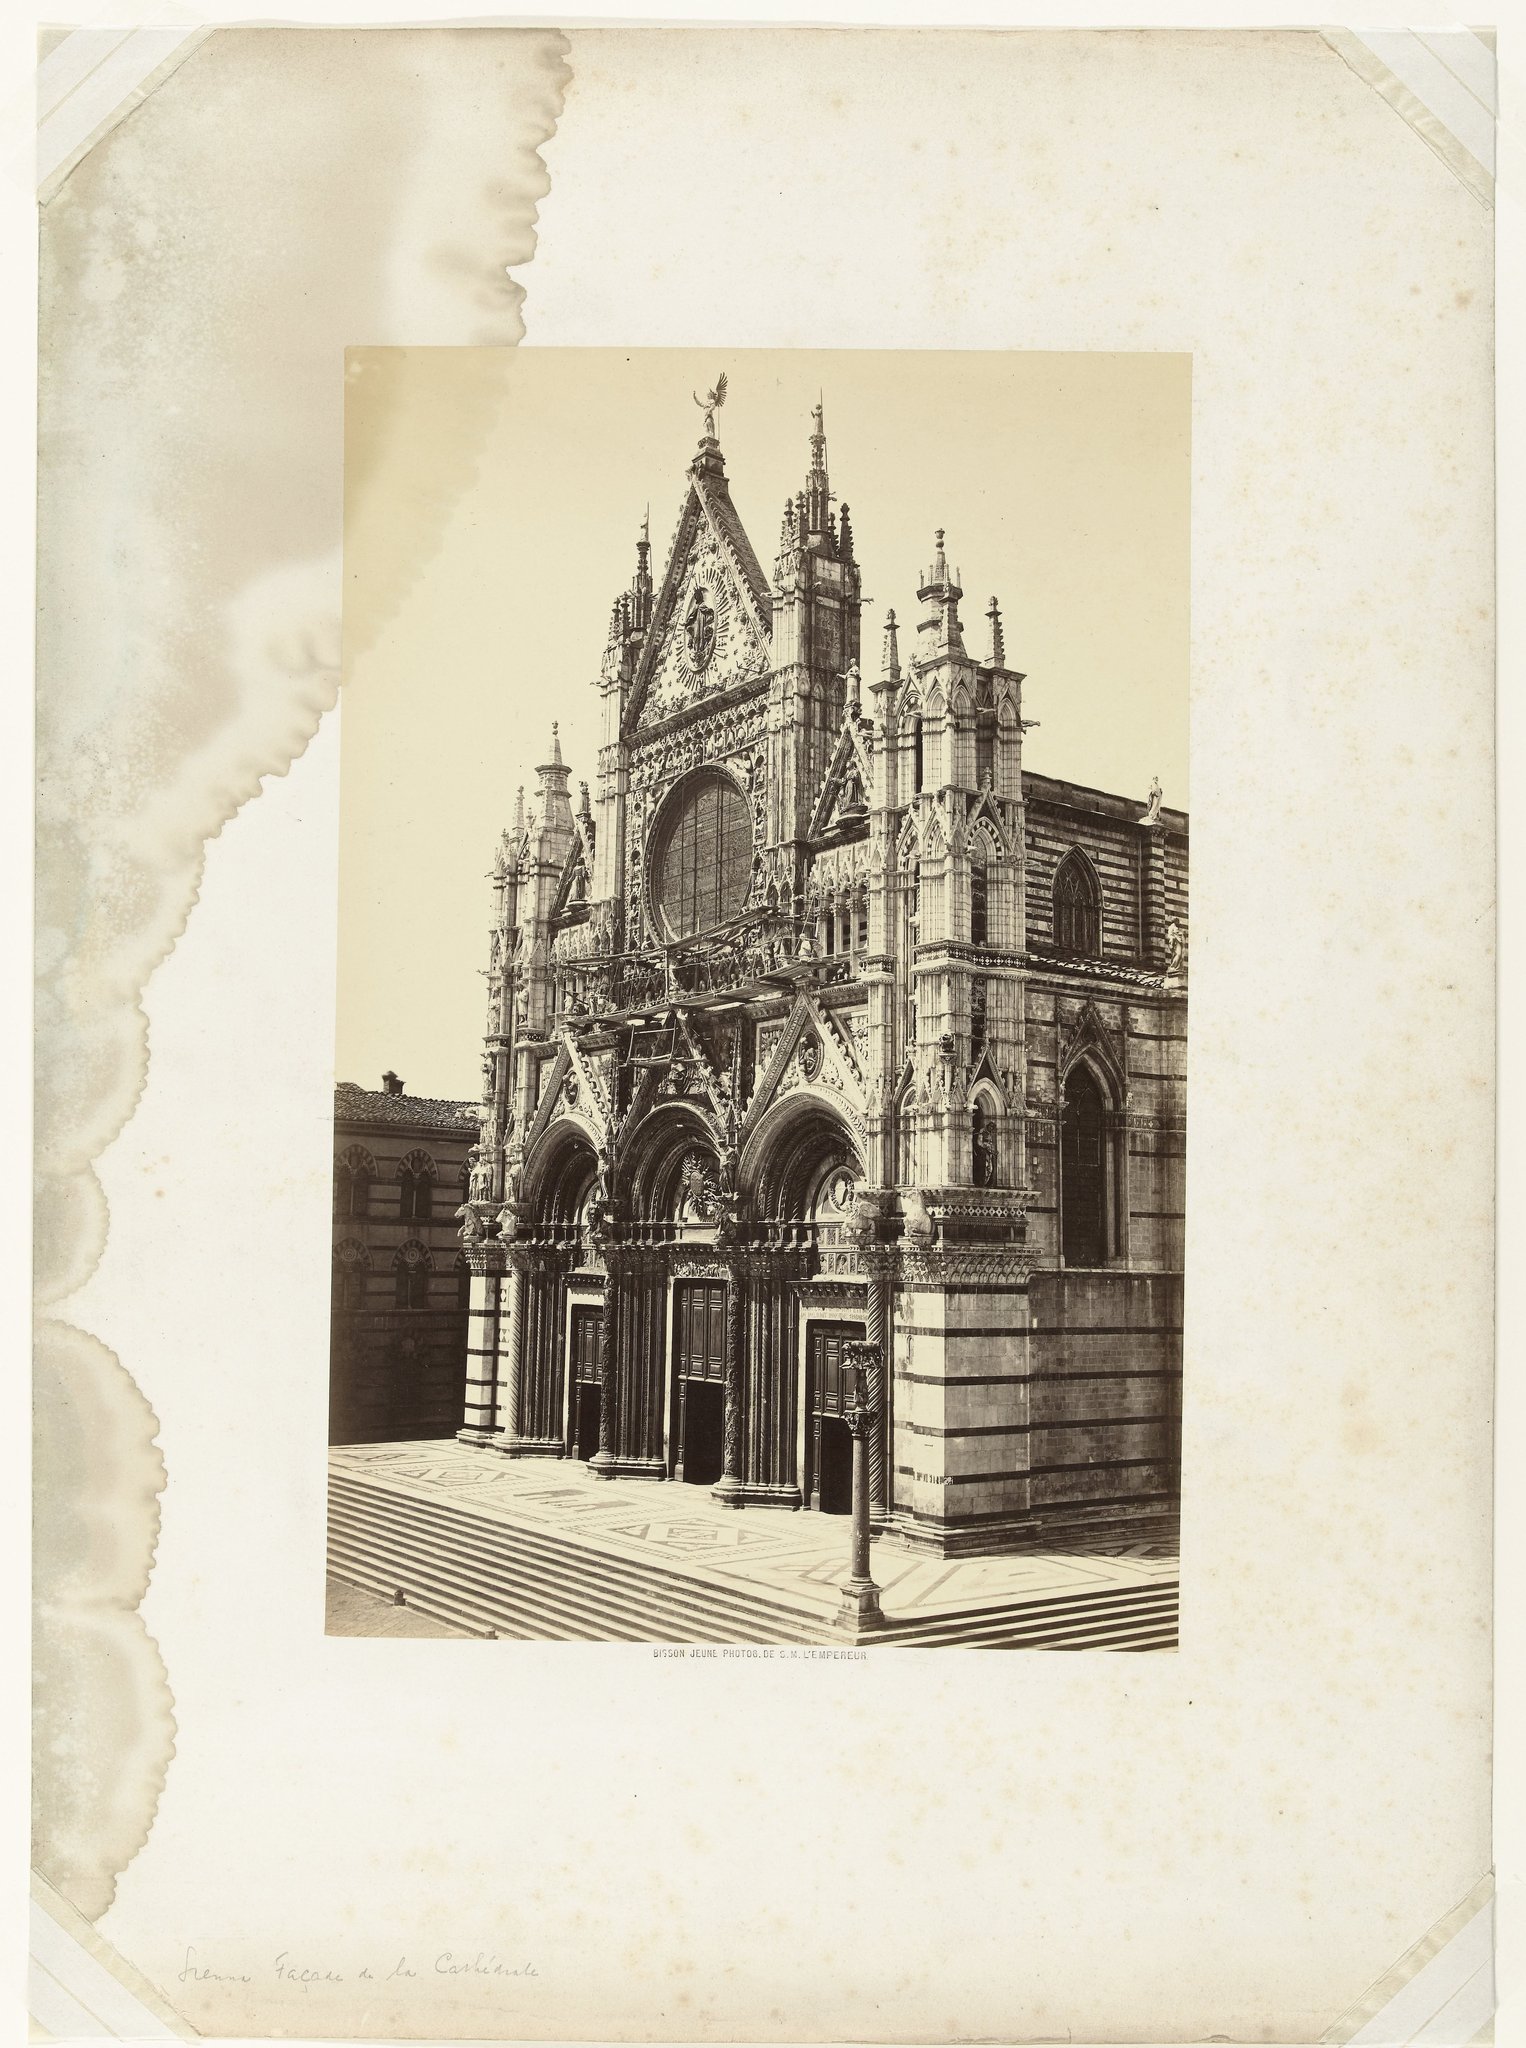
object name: photograph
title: Kathedraal van Siena, Italië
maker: auguste-rosalie bisson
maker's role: fotograaf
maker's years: 1826-1900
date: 1855-1865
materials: cardboard, photographic support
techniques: albumen print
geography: italy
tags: parts of church exterior and annexes